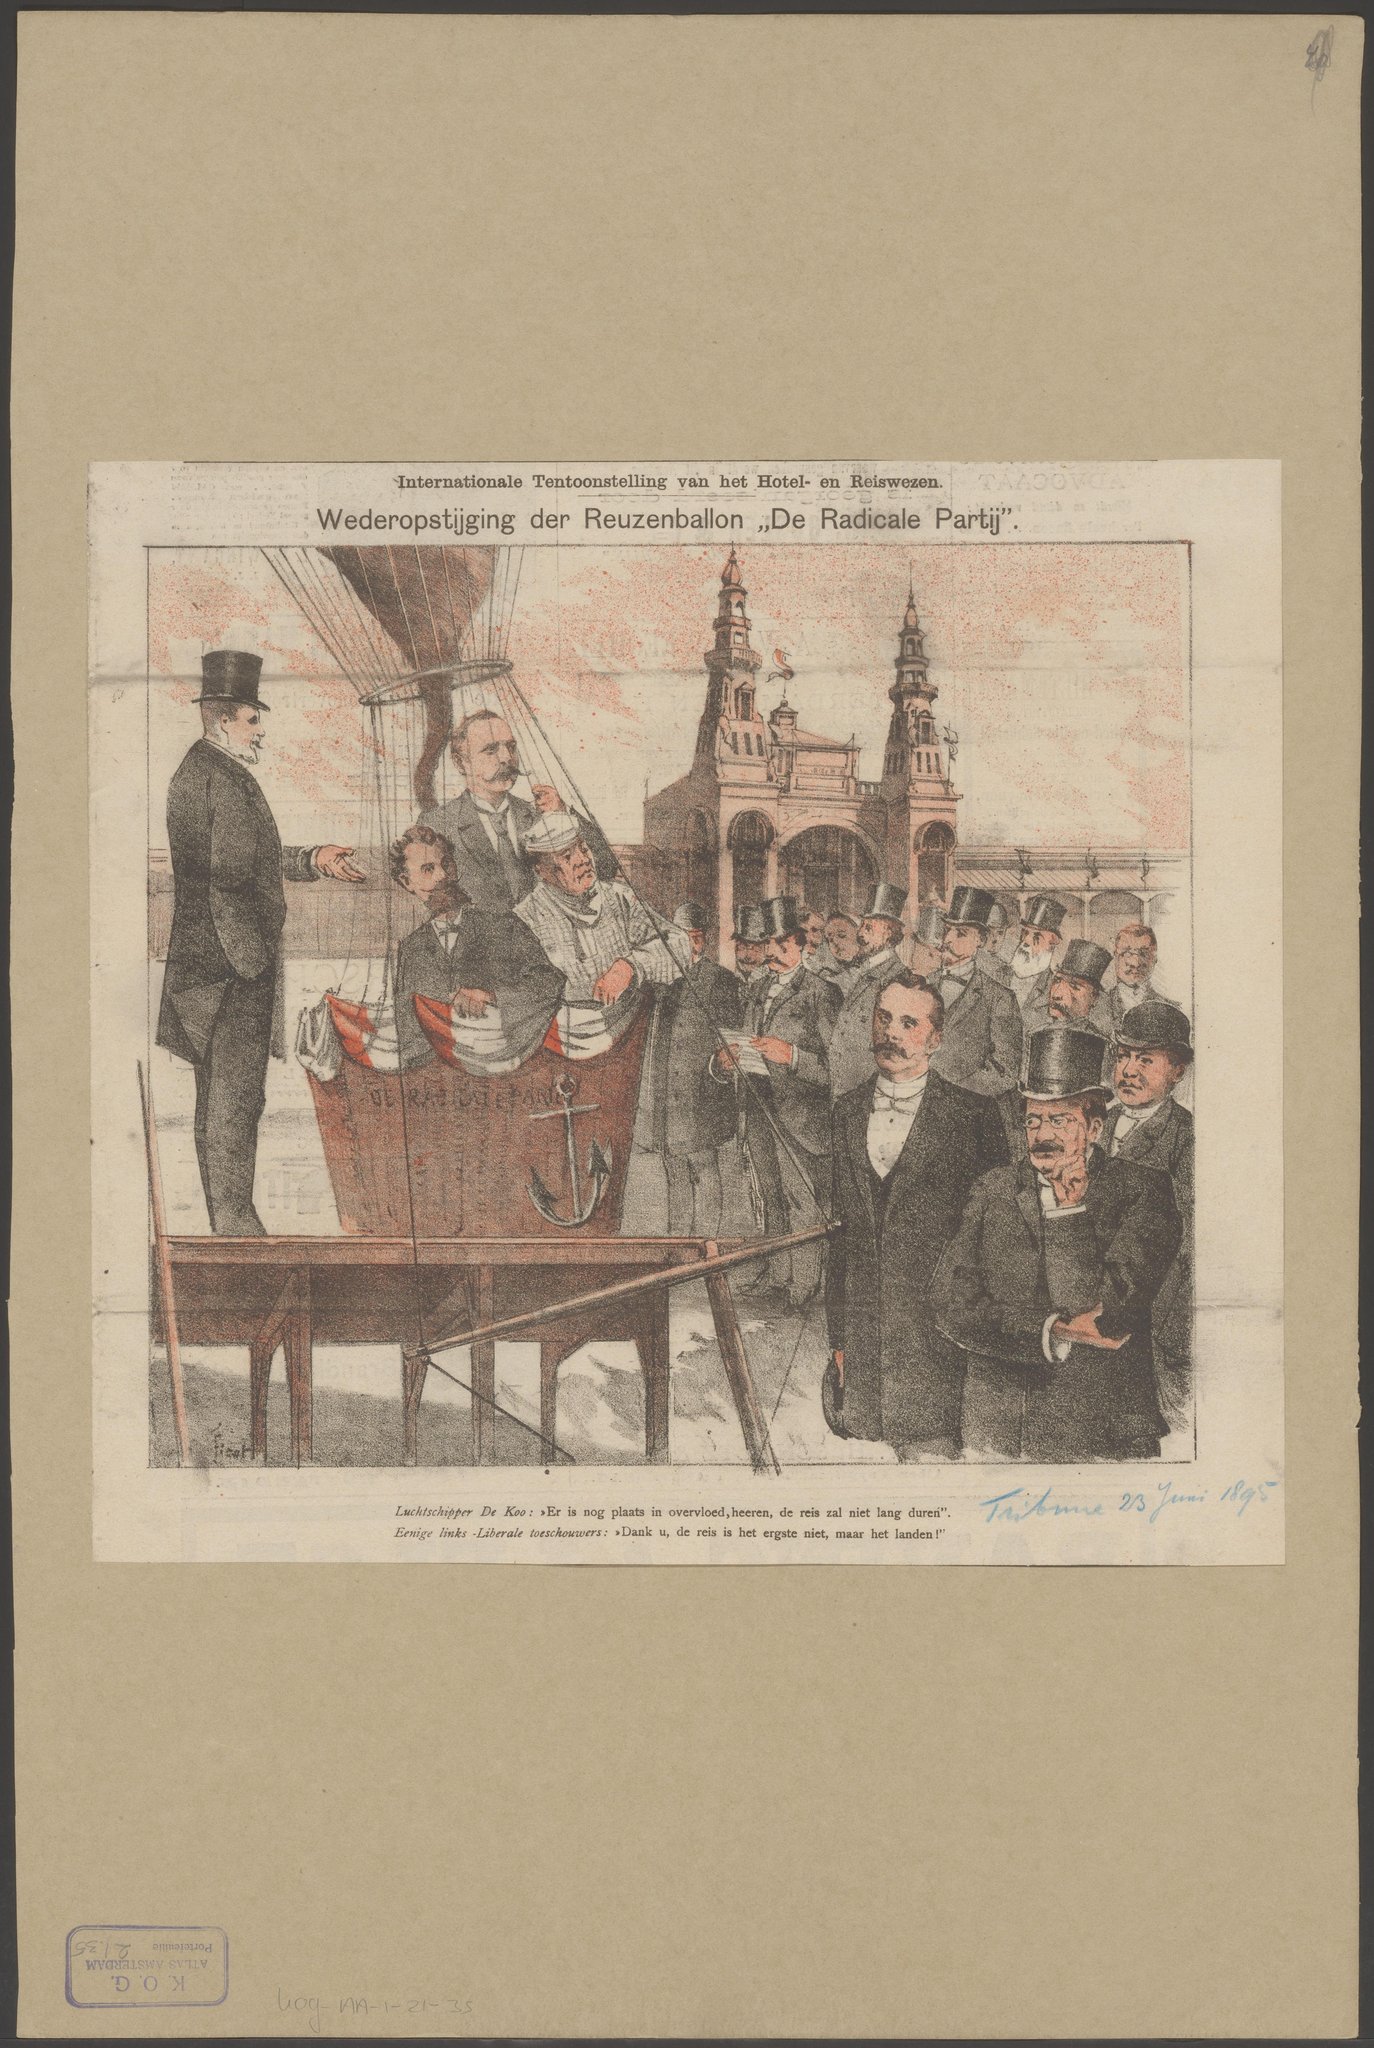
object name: cartoon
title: Wederopstijging der Reuzenballon "De Radicale Partij"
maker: Anonymous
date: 1895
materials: paper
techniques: letterpress printing, lithograph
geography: netherlands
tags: liège, johannes de koo, politician, e.g. party leader, balloon (aviation), parts of ship's exterior: anchor, political caricatures and satires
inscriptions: collector's mark: Lugt 1641b, signature: ‘Ficot (?)’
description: Onderwerpsrubriek binnen de Atlas Amsterdam: Kiesverenigingen, Politieke partijen.